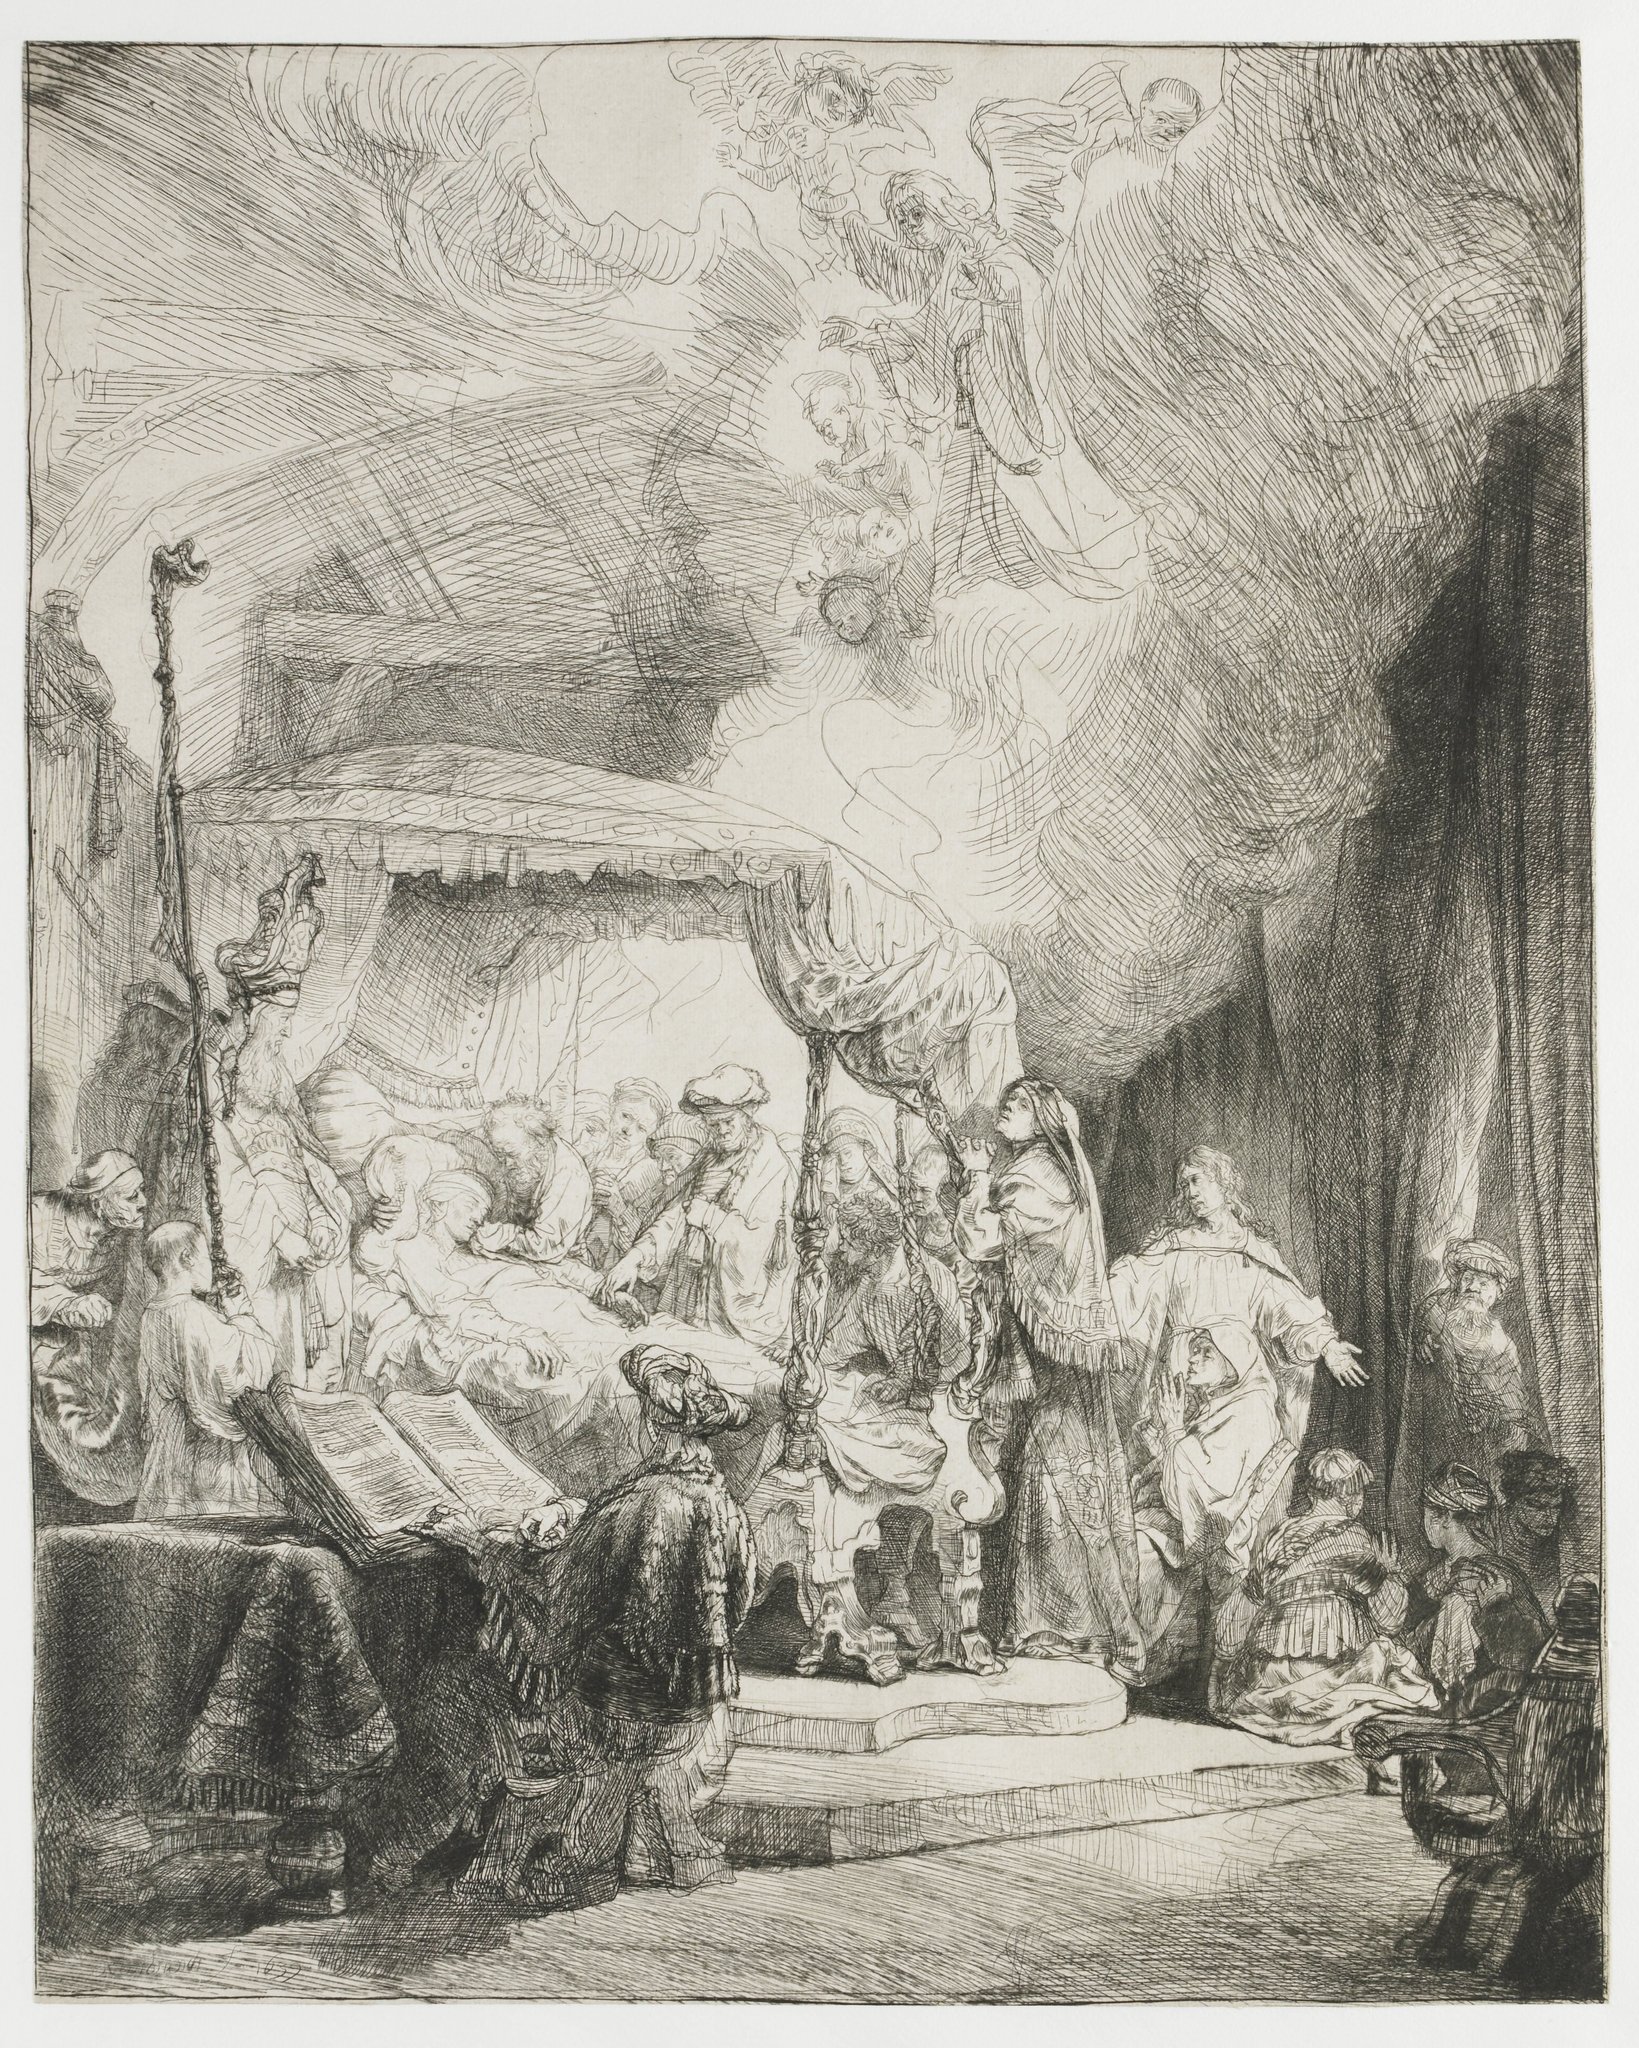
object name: print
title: The death of the Virgin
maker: rembrandt van rijn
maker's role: draughtsman, painter, print maker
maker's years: 1606-1669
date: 1639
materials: paper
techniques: drypoint, etching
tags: the dormition: mary on her deathbed; the apostles are gathered around her (john the evangelist may be shown sleeping or dreaming)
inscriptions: mark: Lugt 2228, signature and date: ‘Rembrandt f 1639’